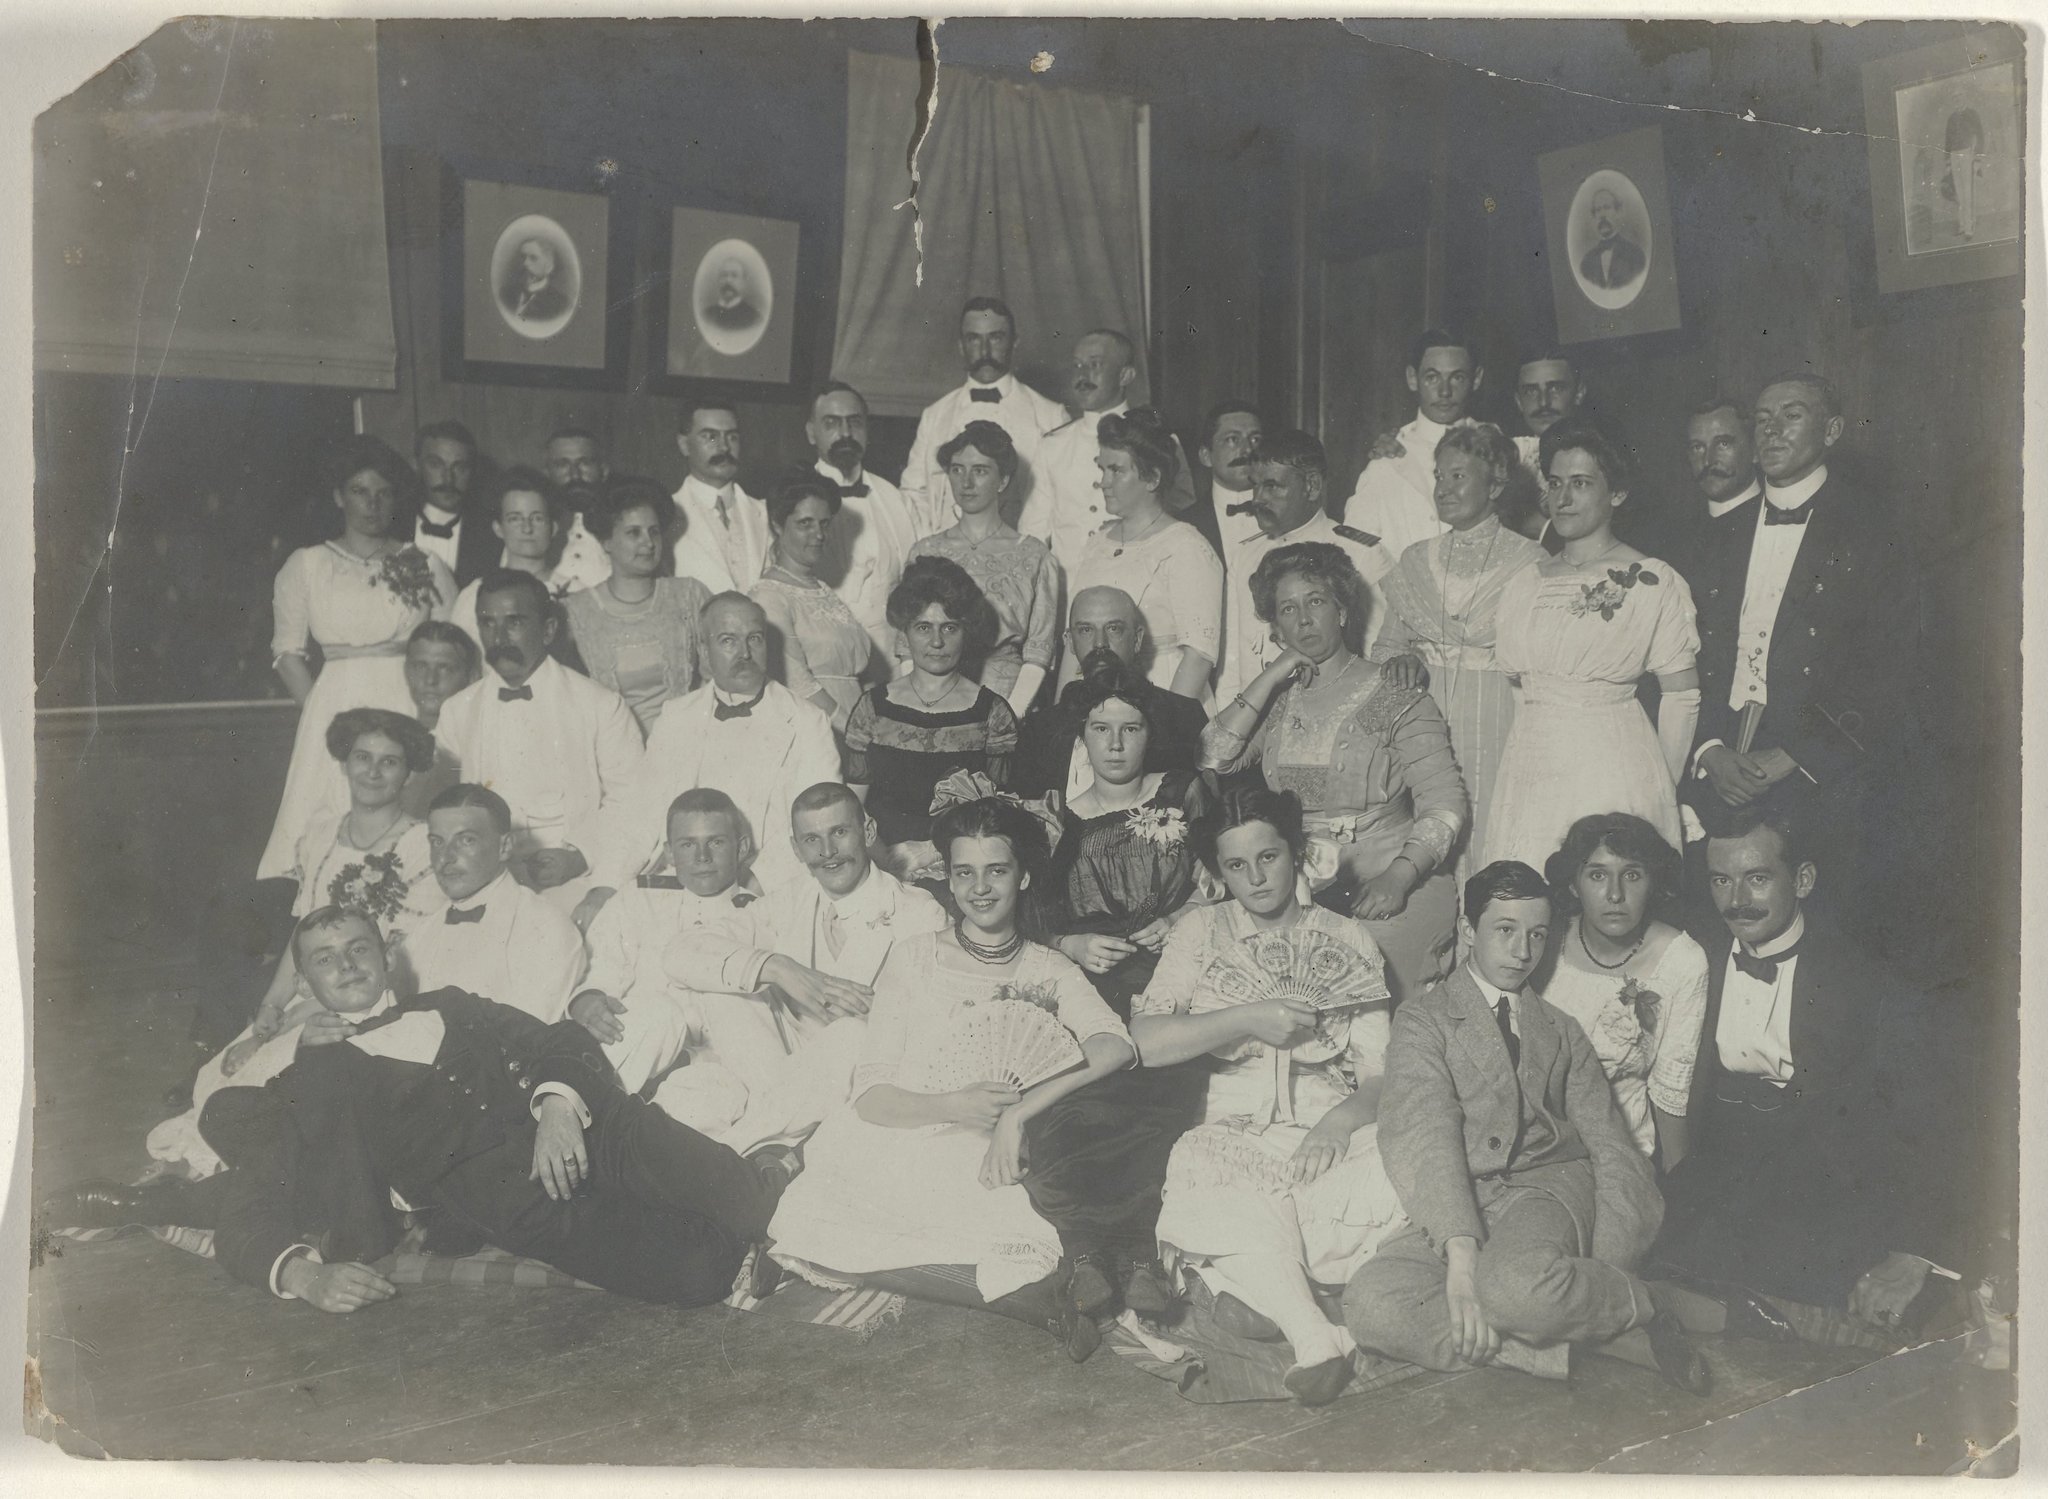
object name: photograph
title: Feestelijk gezelschap in Suriname, onder wie Maria Gonggrijp ("Poppie")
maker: Anonymous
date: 1904-1912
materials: photographic support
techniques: photography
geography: paramaribo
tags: anonymous historical persons portrayed in a group, in a group-portrait, suriname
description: Groepsfoto van een feestelijk gezelschap in Suriname, onder wie Maria Gonggrijp. Onderdeel van een groep foto's van de familie Boom-Gonggrijp in Suriname.